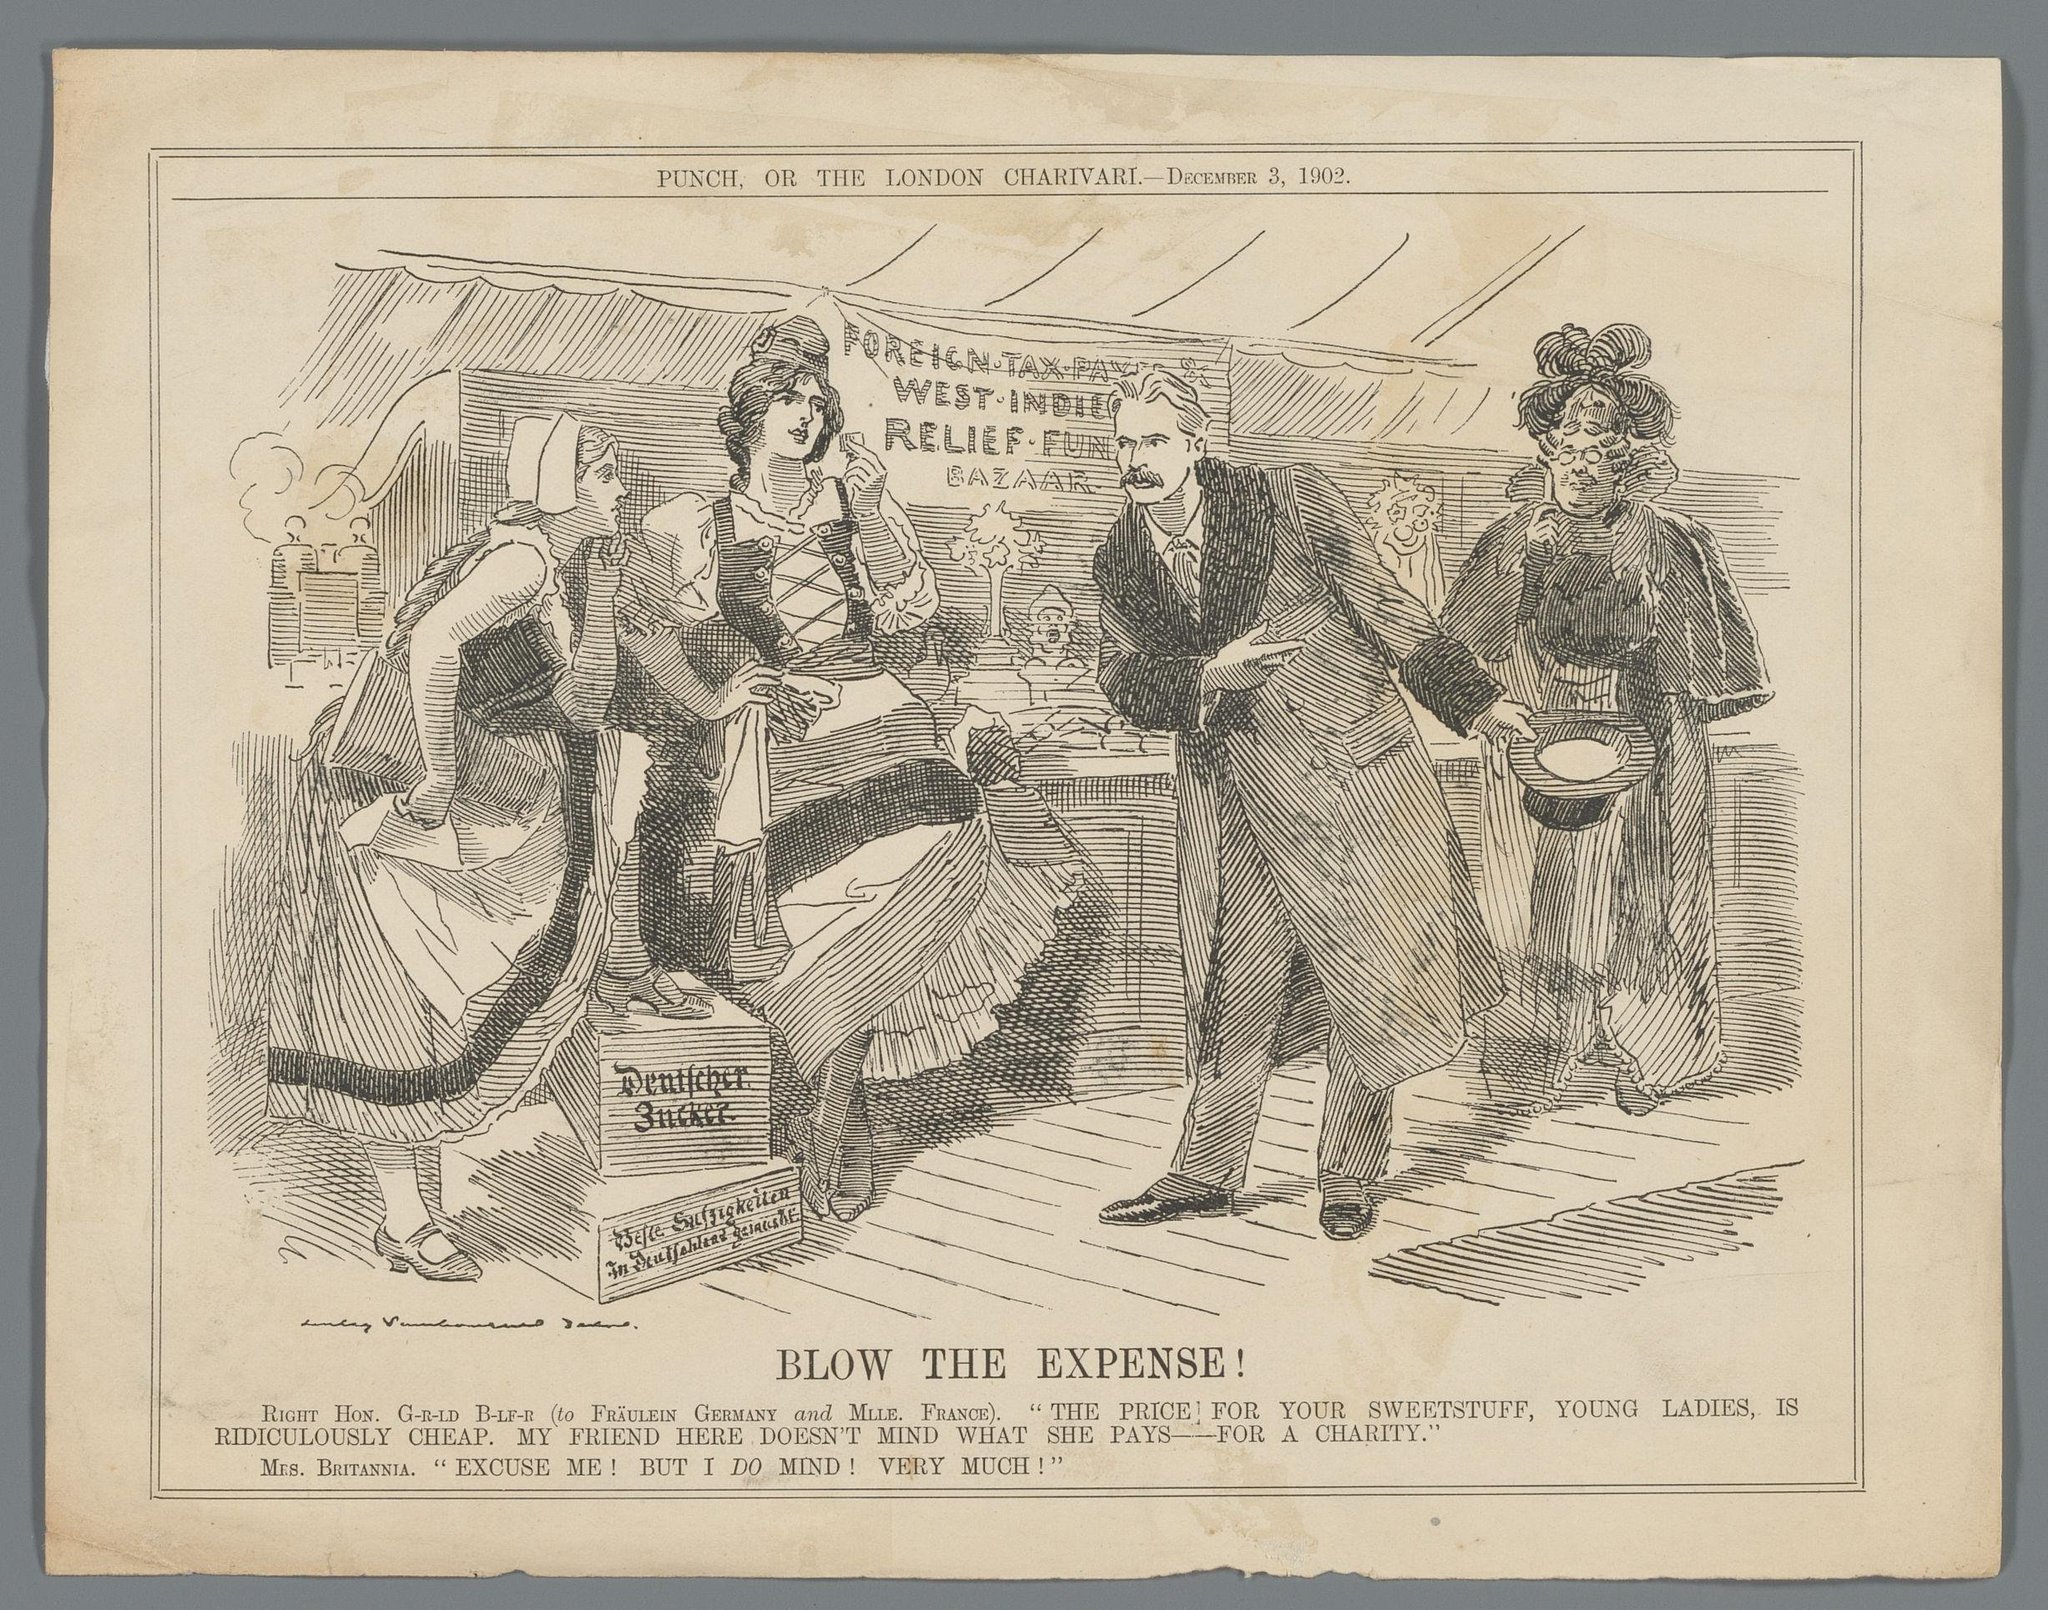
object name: print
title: Gerald Balfour koopt zoetigheden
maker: edward linley sambourne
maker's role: draughtsman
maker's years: 1844-1910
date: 1902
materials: paper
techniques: line block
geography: england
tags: earl, politician, personifications of countries, nations, states, districts, etc., sugar-candy, charitable works, political caricatures and satires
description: Spotprent met de Britse 'President of the Board of Trade' die zoetigheden koopt bij de jonge Duitse en Franse maagden voor een hoge prijs. De oude Britannia protesteert hier tegen. Op een bazaar om geld in te zamelen ten bate van Brits West-Indië. Spotprent uit het Engelse satirische tijdschrift Punch, 3 december 1902.